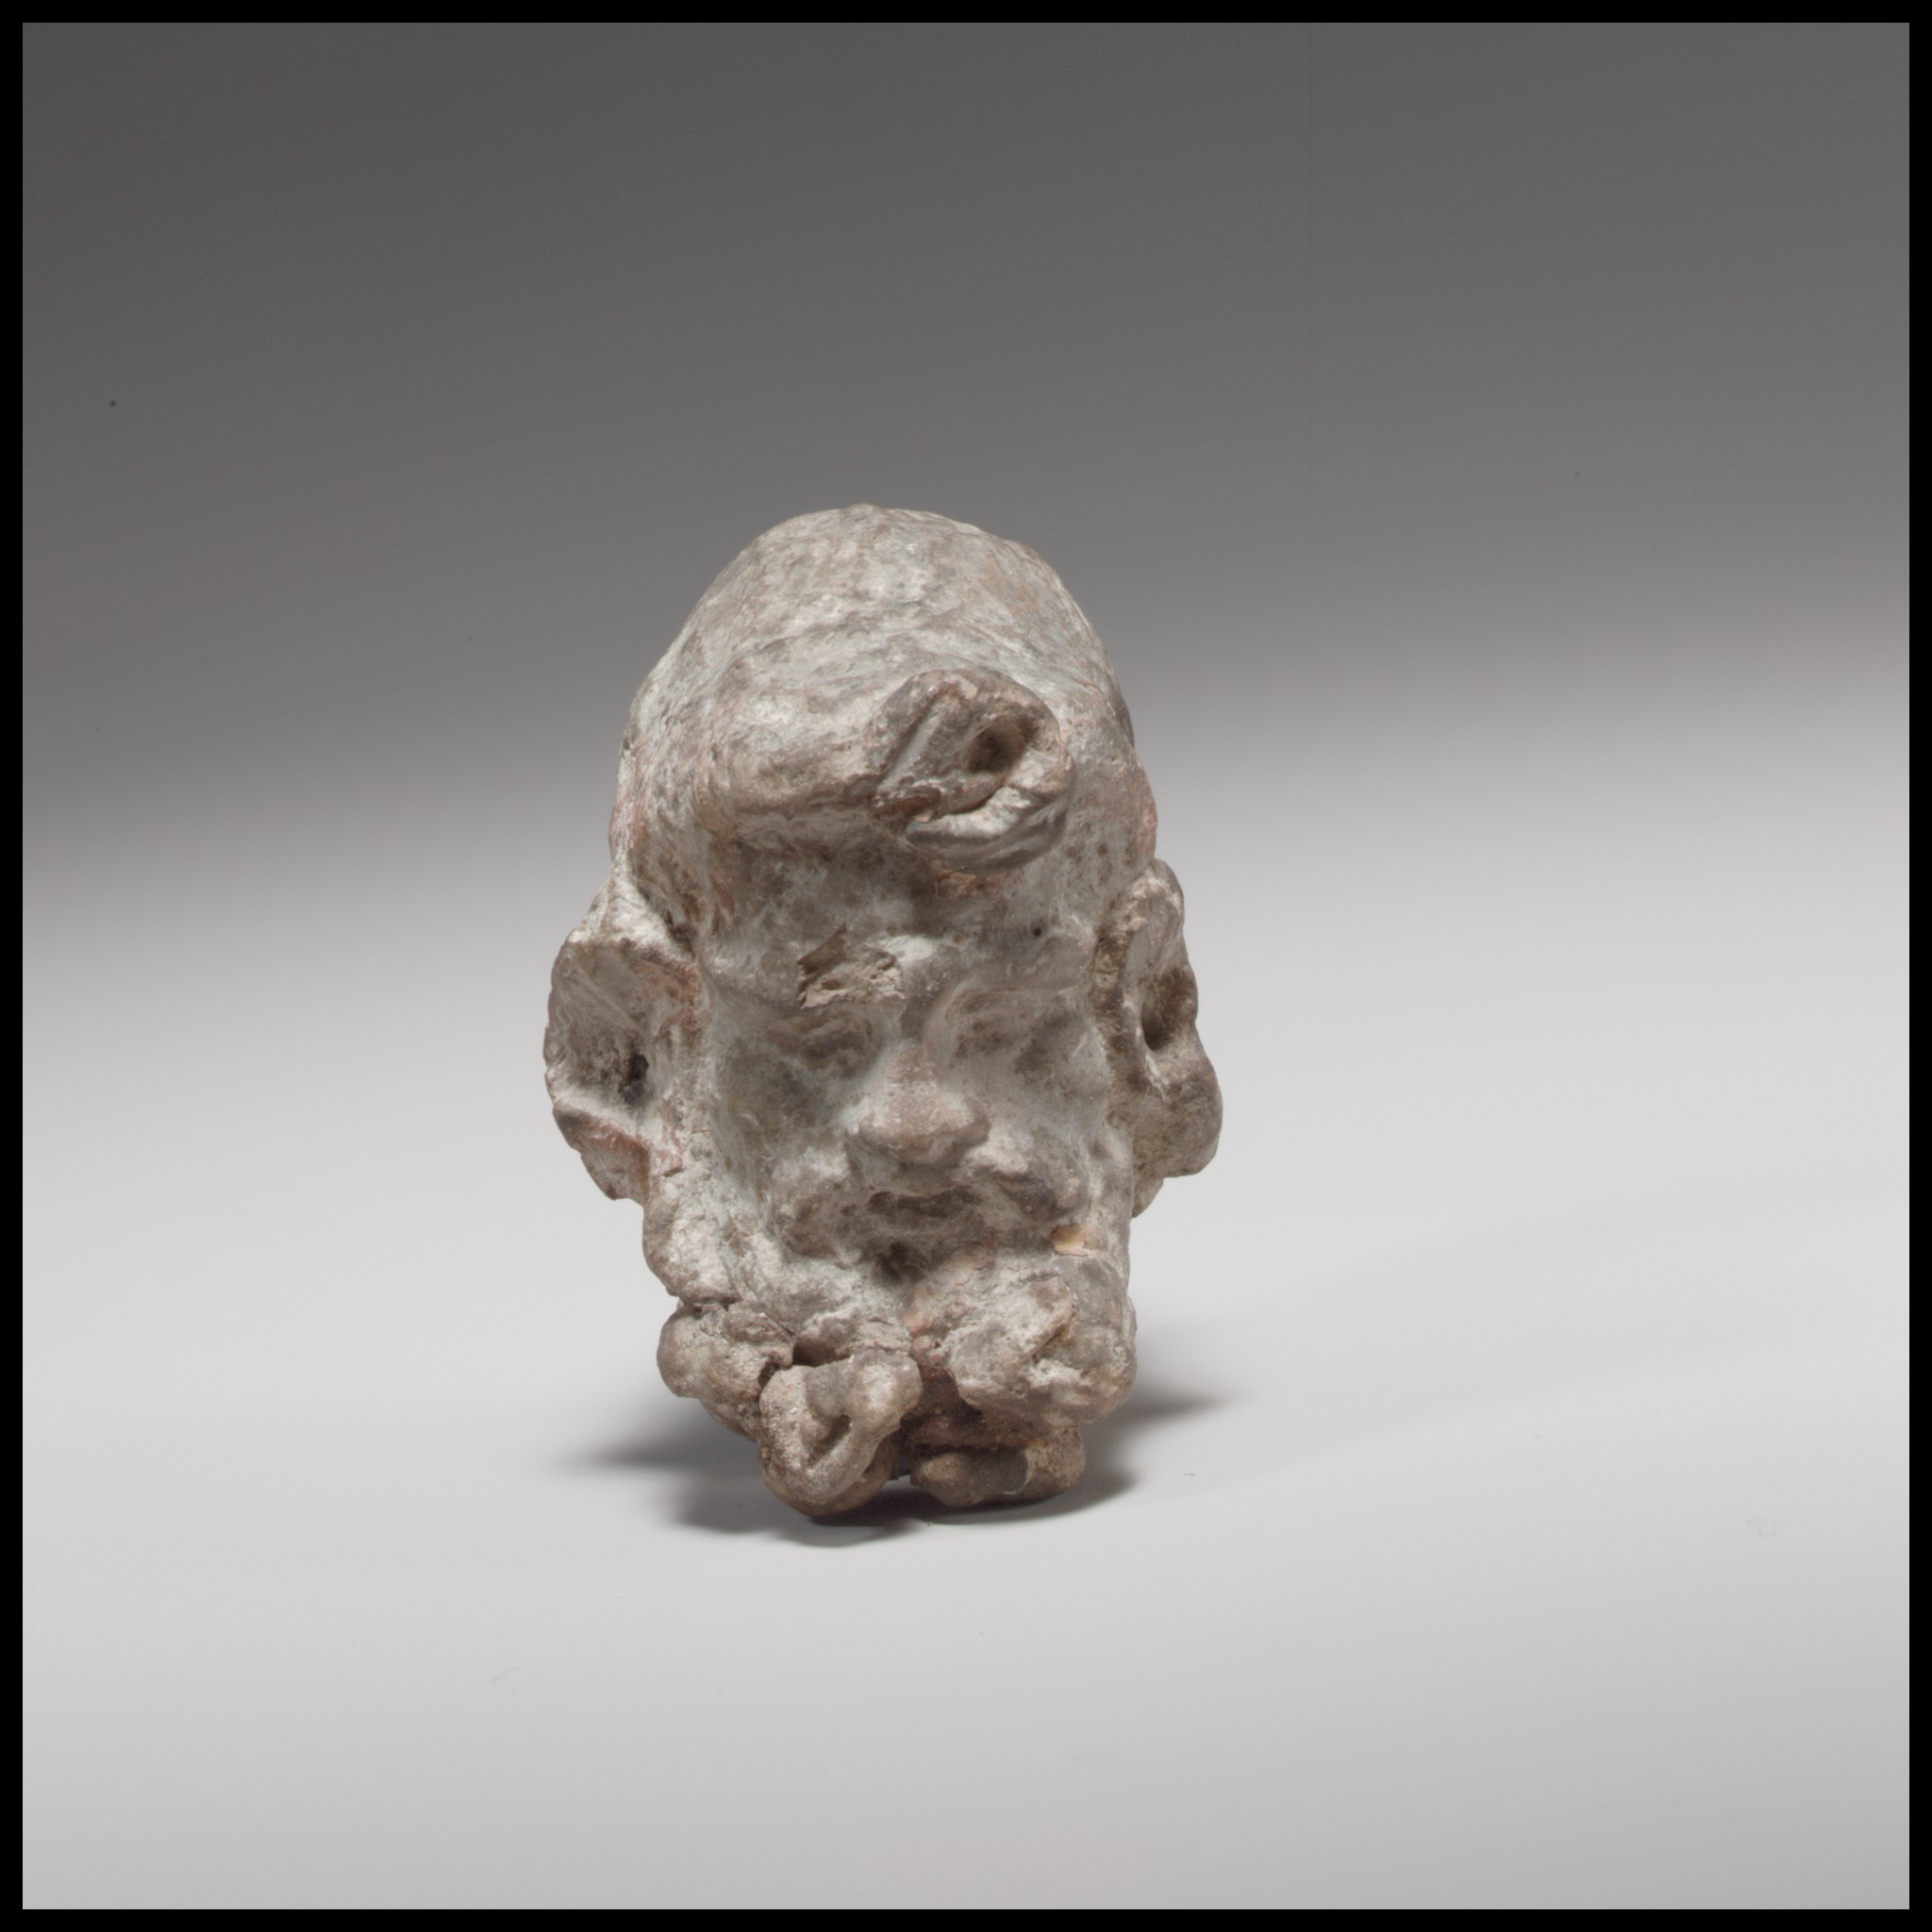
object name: head of silenos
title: Head of a satyr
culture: cypriot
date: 200-101 BCE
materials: terracotta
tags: satyrs